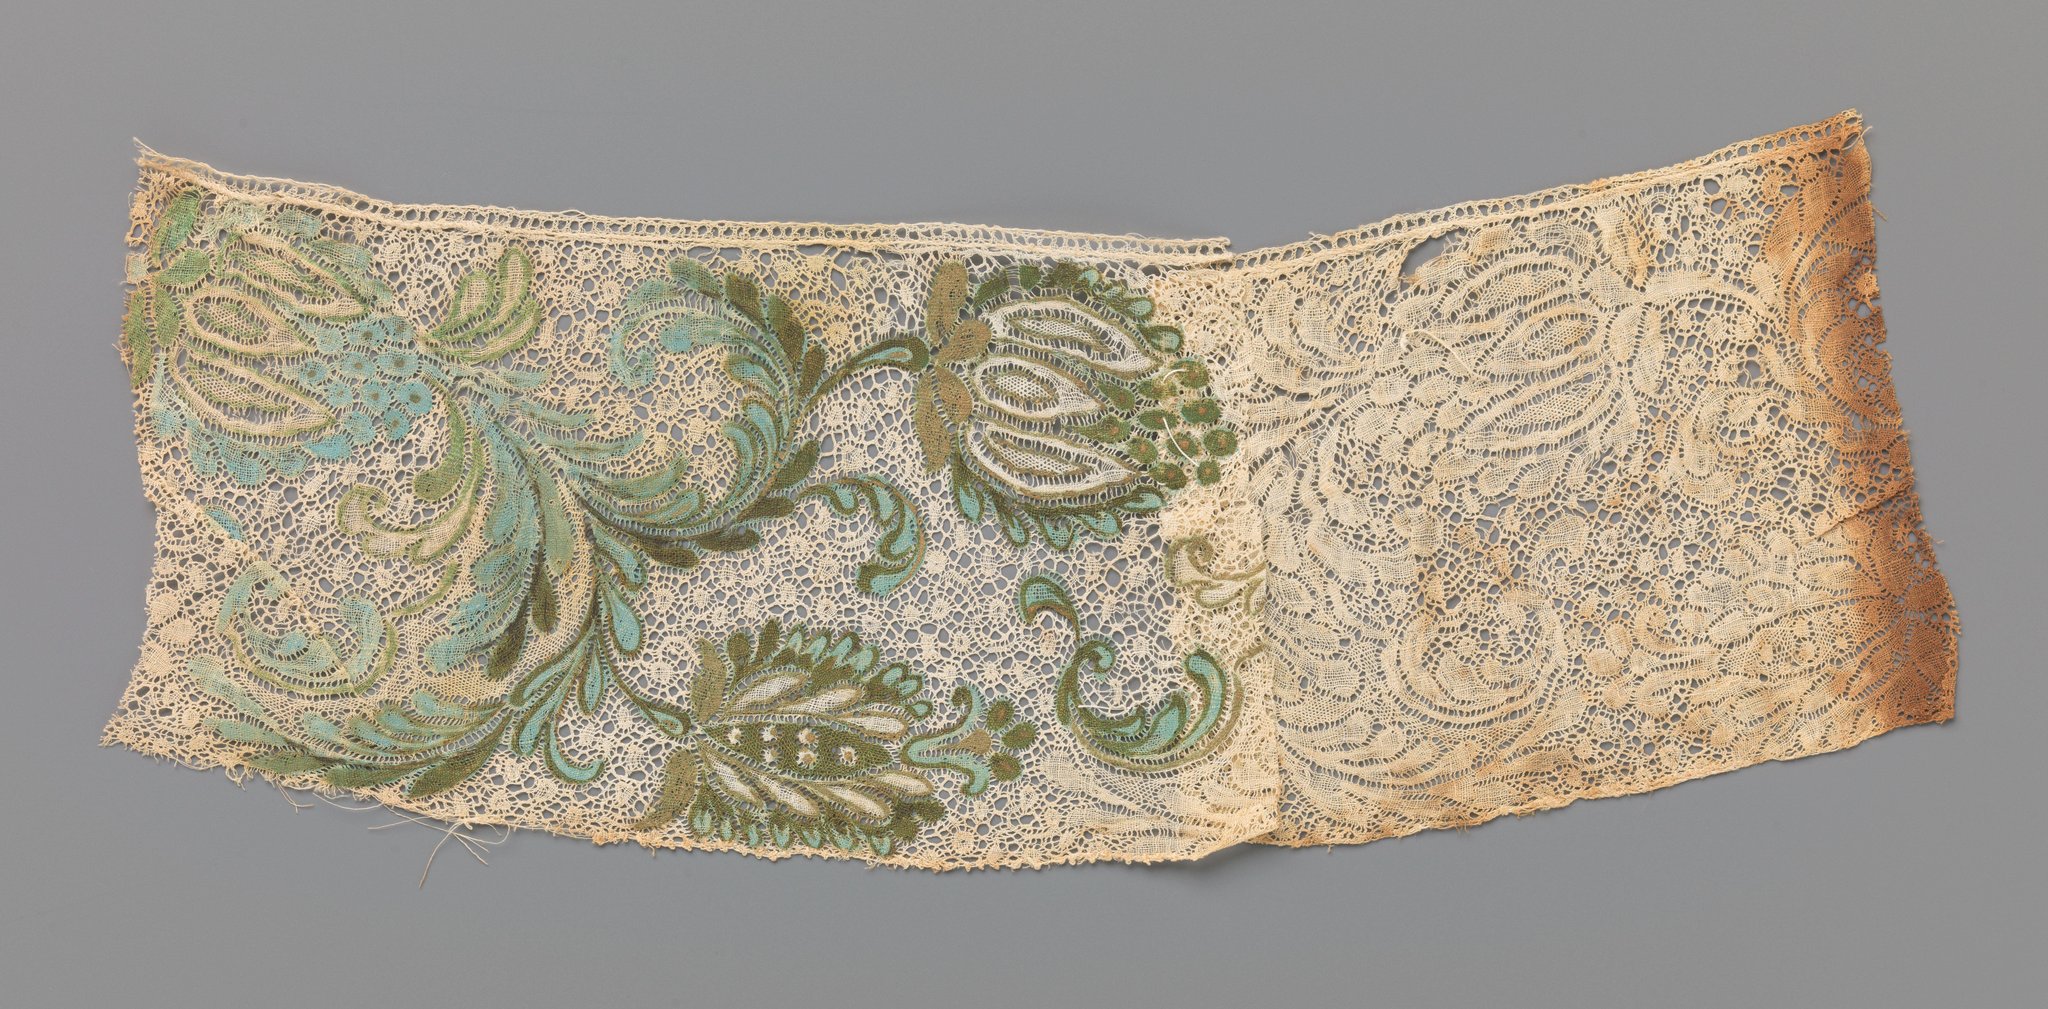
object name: strip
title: Strook kloskant zonder beschilderde bloemen en bladeren in een serie stroken die wel beschilderd is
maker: Anonymous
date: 1740-1760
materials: linen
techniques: lace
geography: southern netherlands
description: Strook naturelkleurige kloskant, Binche-kant, met enkele steken vastgenaaid aan een blauw en groen beschilderde strook met hetzelfde patroon. Het patroon bestaat uit gevederde bladeren, gebogen en omkrullend, met een pluimvormige bloem en een bloem in de vorm van een dennenappel. De motieven zijn met elkaar verbonden door een siergrond, een sneeuwvlokkengrond. Het volwerk is grotendeels gemaakt in linnenslag met opengewerkte randjes. Tussen sommige bladeren en in de bloemen is een netslagvulling toegepast. De onderzijde van de strook is recht afgewerkt. De bovenzijde is afgewerkt met een apart geklost bandje. Een randje langs één korte kant is sterk bruin verkleurd.